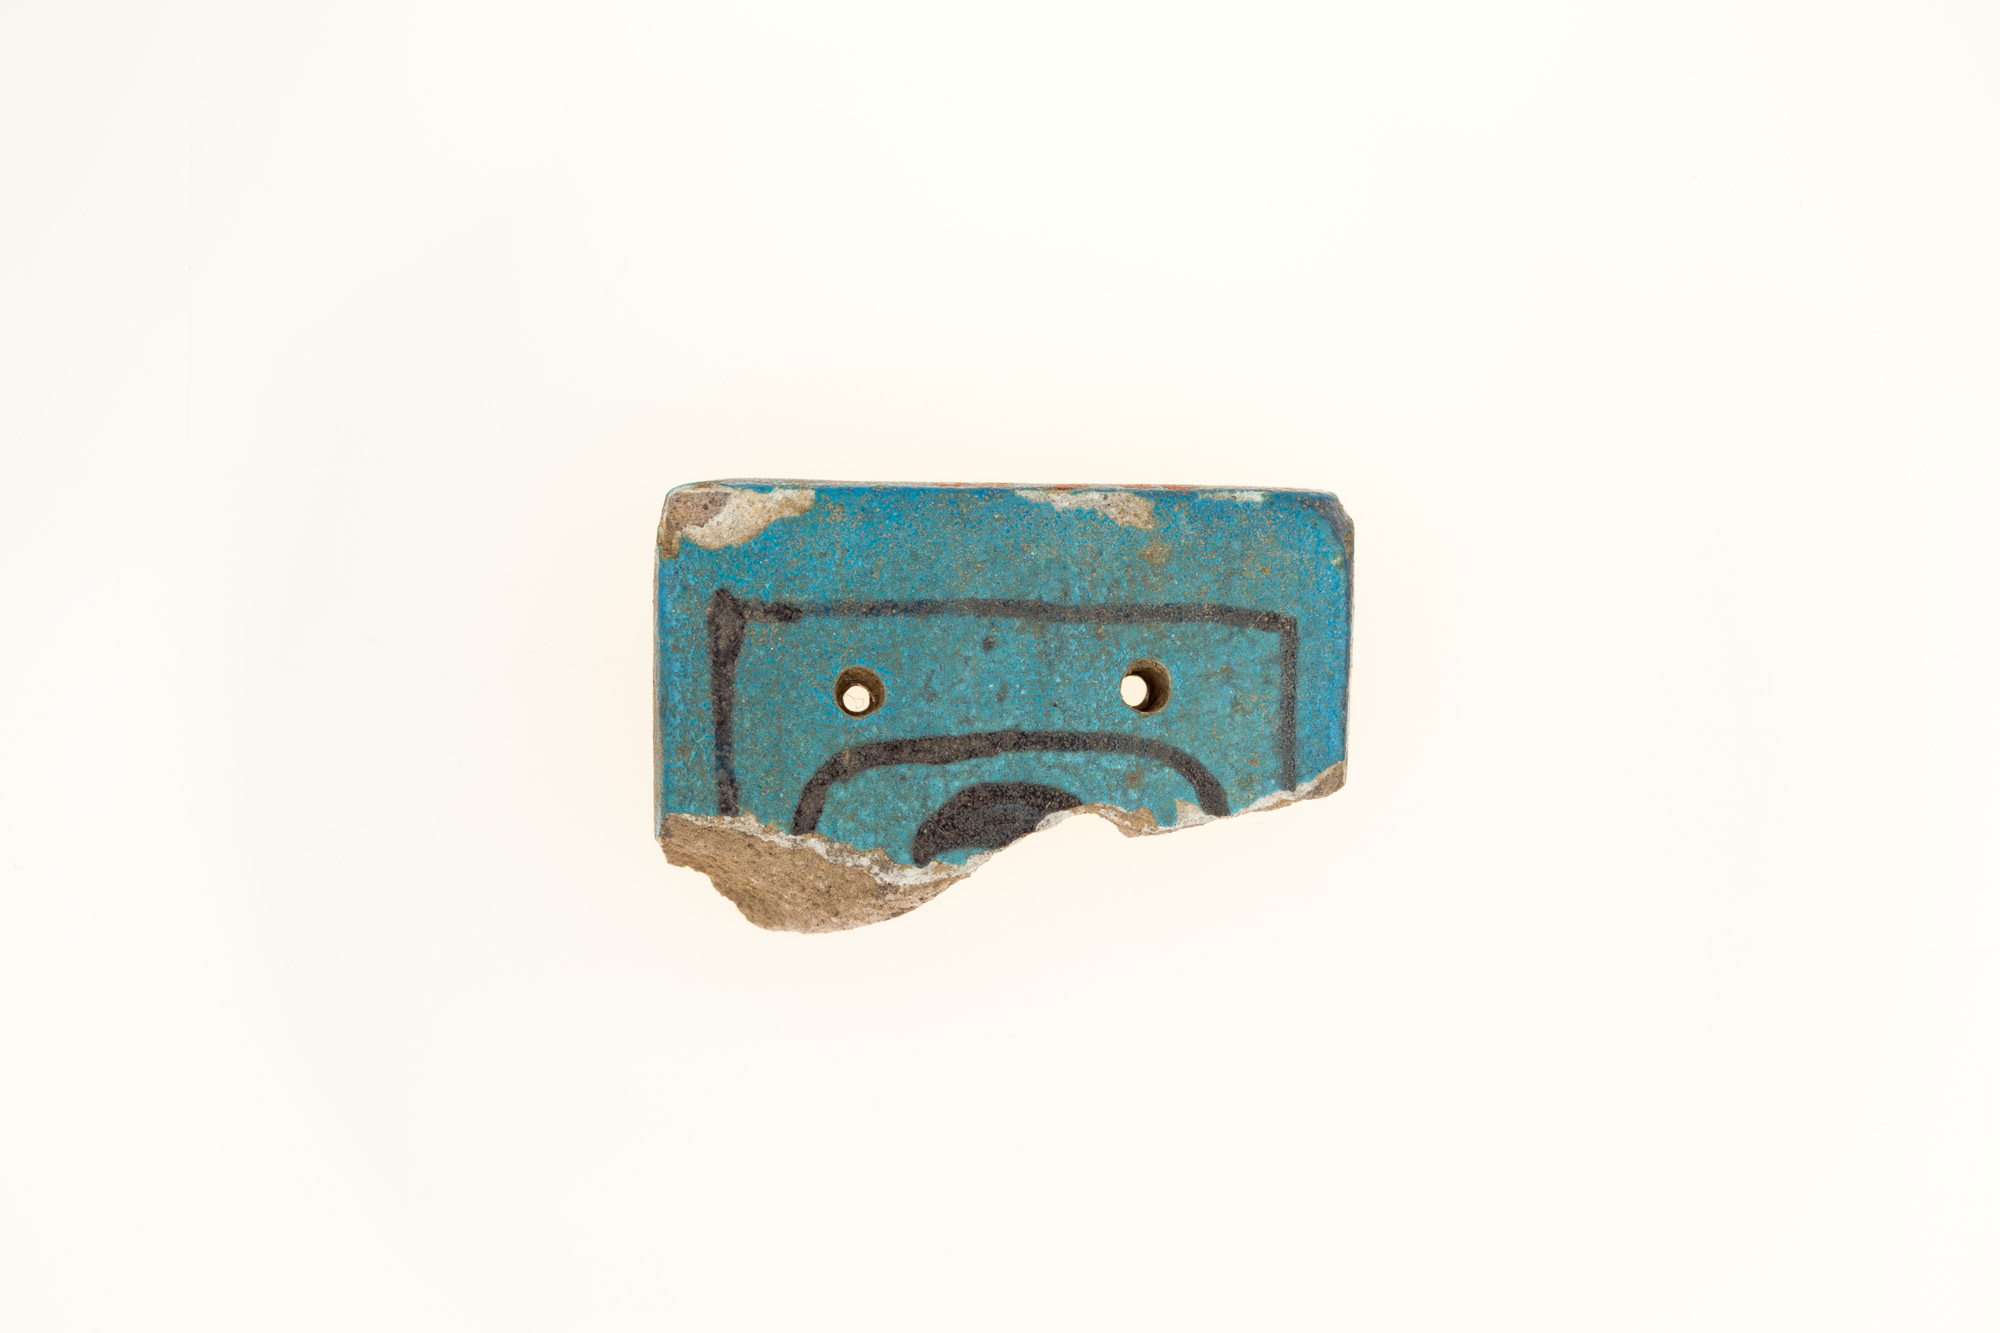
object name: menat fragment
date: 1479-1458 BCE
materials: faience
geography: egypt